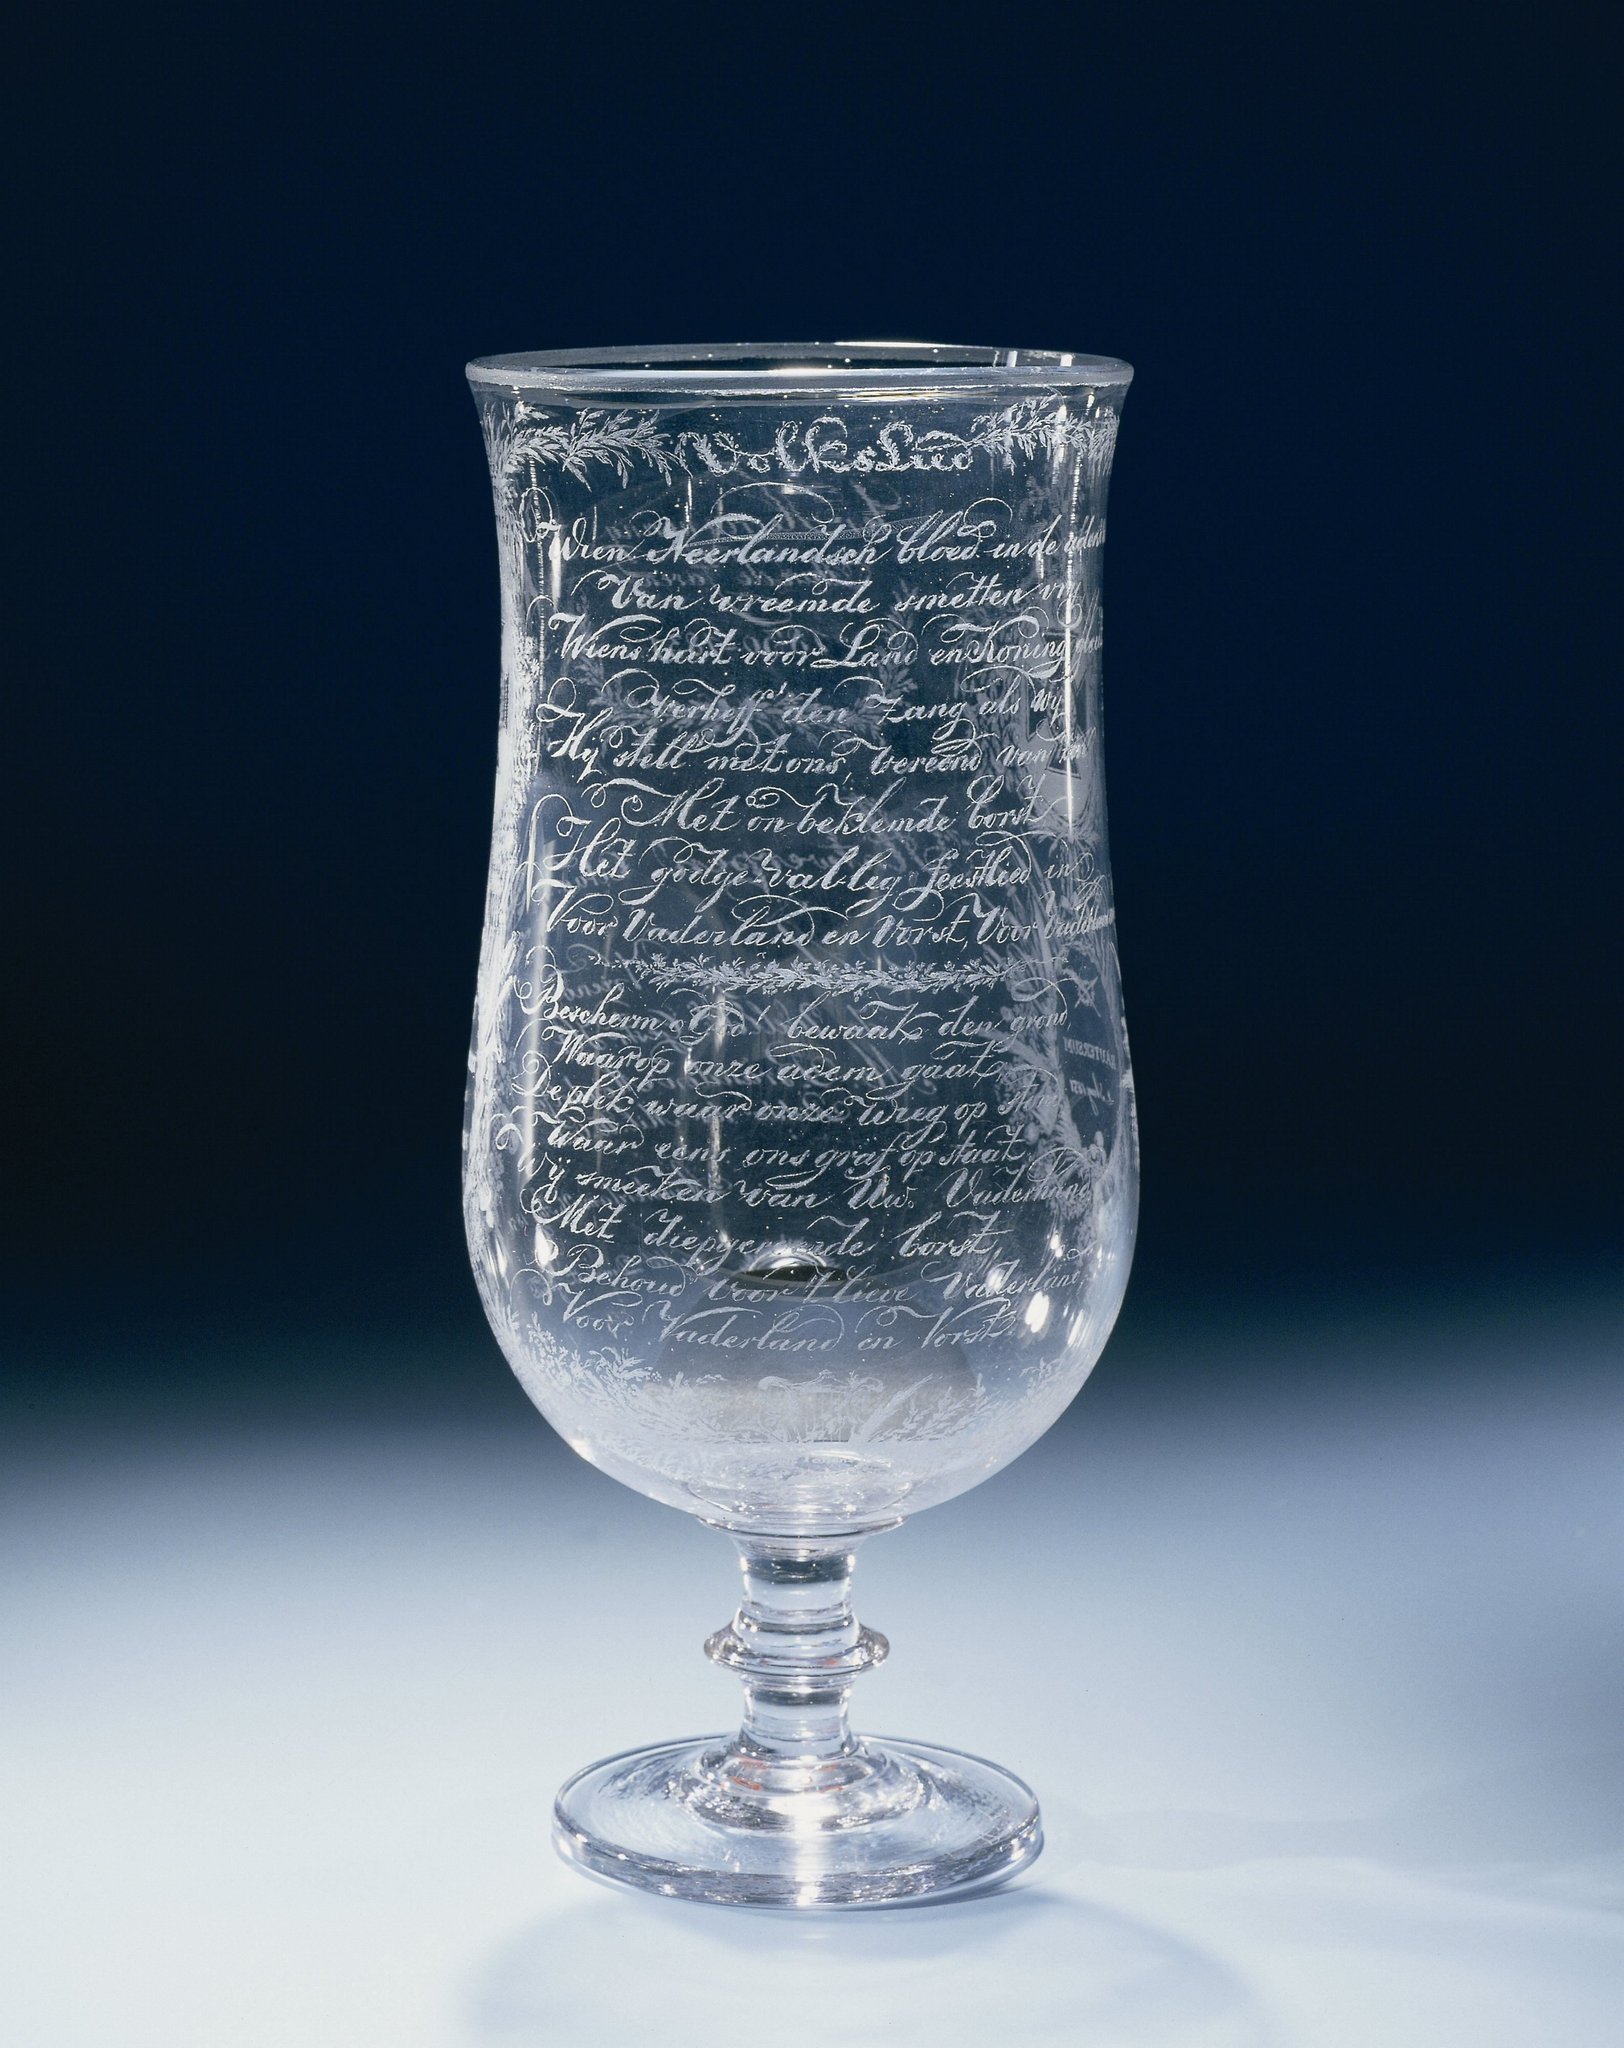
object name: vase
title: Vaas met twee coupletten van het volkslied Wien Neerlandsch bloed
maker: daniël henriques de castro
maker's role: glasgraveur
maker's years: 1806-1863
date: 1856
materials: glass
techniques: diamond point engraving, etching, glassblowing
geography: amsterdam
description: Platte voet. Korte stam met één schijf. Hoge, tulpvormige kelk, waarop onder de kop Volkslied twee coupletten van Wien Neerlandsch bloed zijn gegraveerd; eronder, in een ovaal medaillon de naam Tollens, omgeven door een lier, trompet en ganzeveer tussen bloemranken. Op de andere zijde de inscriptie Ter herrinnering Aan de Jaren 1830-1831 Antwerpen. Citad.l Aan mijnen Vriend de Weled.l Gestr. Hr. M. Brandon Mondolfo Ridder der Mil. W. Orde. Daaronder Amsterdam 26 Aug 1856 met Diamant getek. en in een kleine, ovale oneffenheid in de glasmassa de signatuur en het jaartal DH d C fec 1856. Voorts zijn op het glas gegraveerd het IJzeren Kruis met een medaillon met de namen van de steden Hasselt en Leuven en een tweede IJzeren Kruis met een medaillon met de naam van de stad Bautersum en de datum 8 aug 1831.